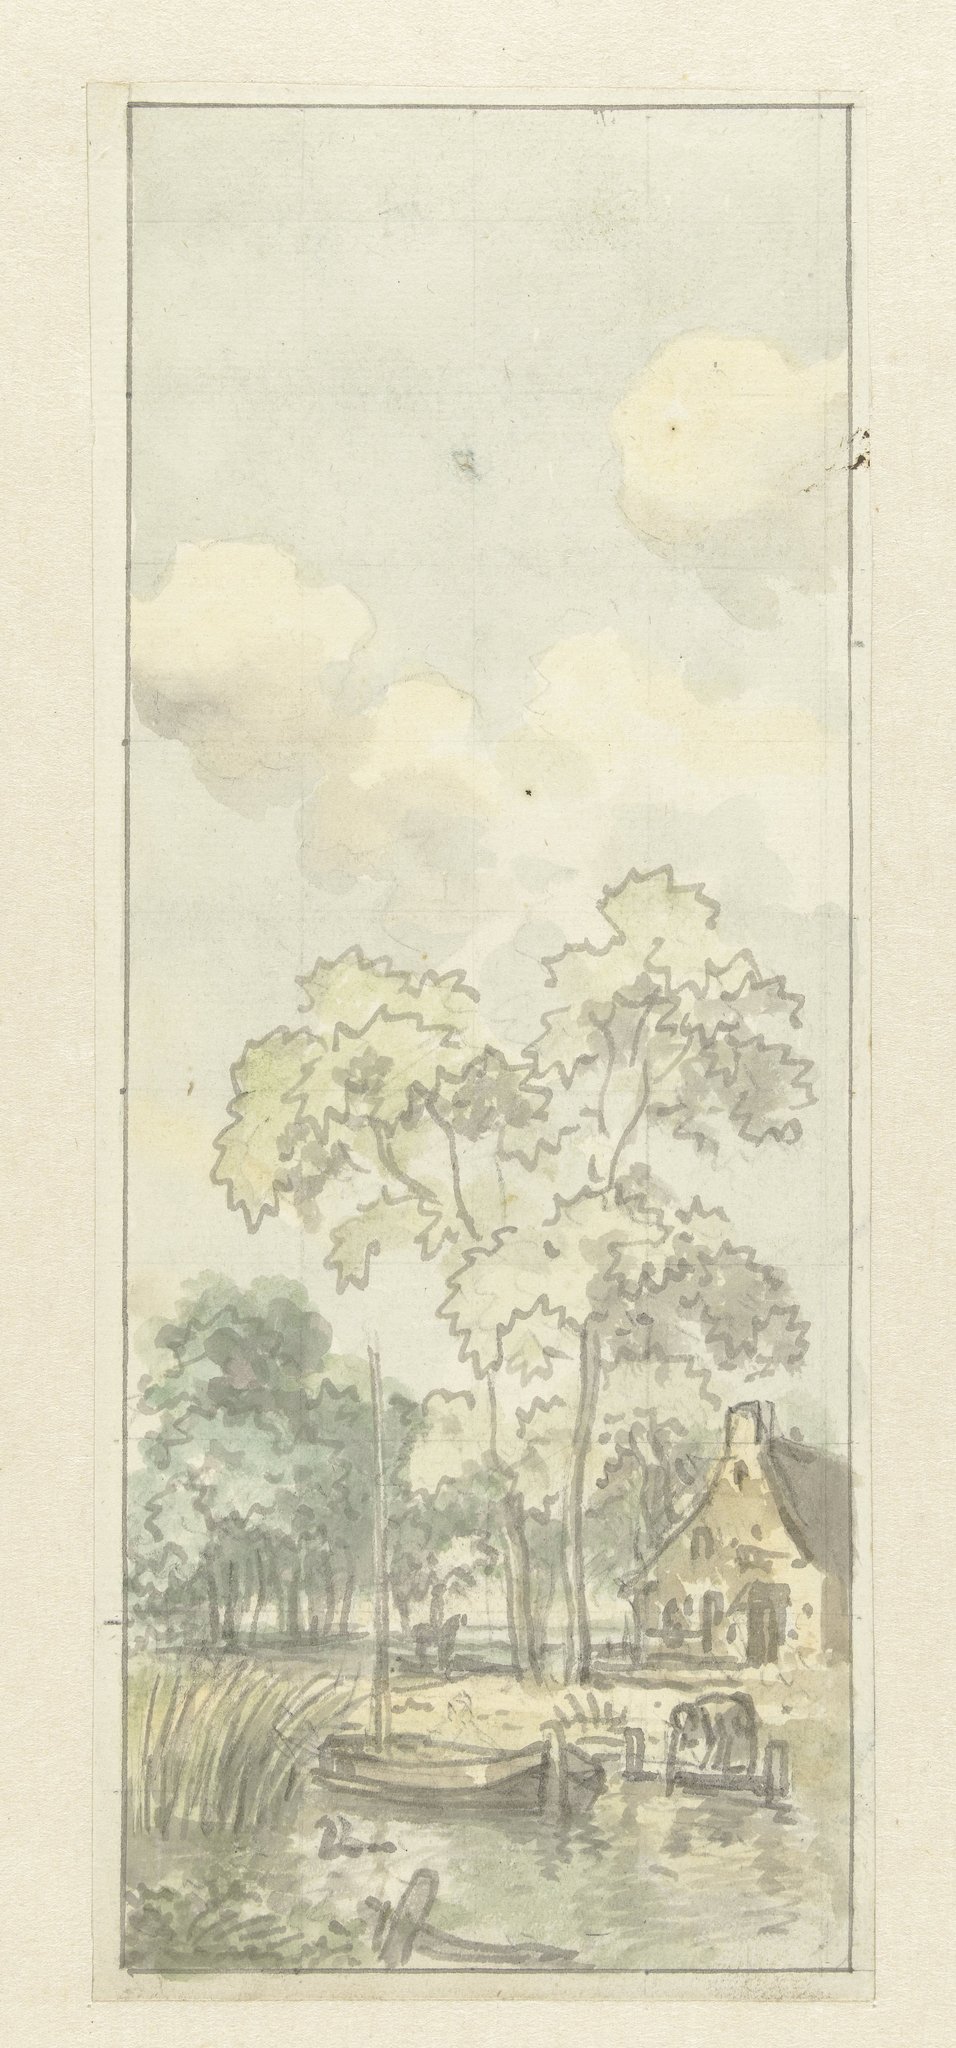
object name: design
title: Ontwerp voor behangselschildering met Hollands landschap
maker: jurriaan andriessen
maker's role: draughtsman, painter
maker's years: 1742-1819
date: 1752-1819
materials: graphite, ink, paper, pencil, watercolor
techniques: brush, pen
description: Ontwerp voor behangselschildering: Hollands landschap.